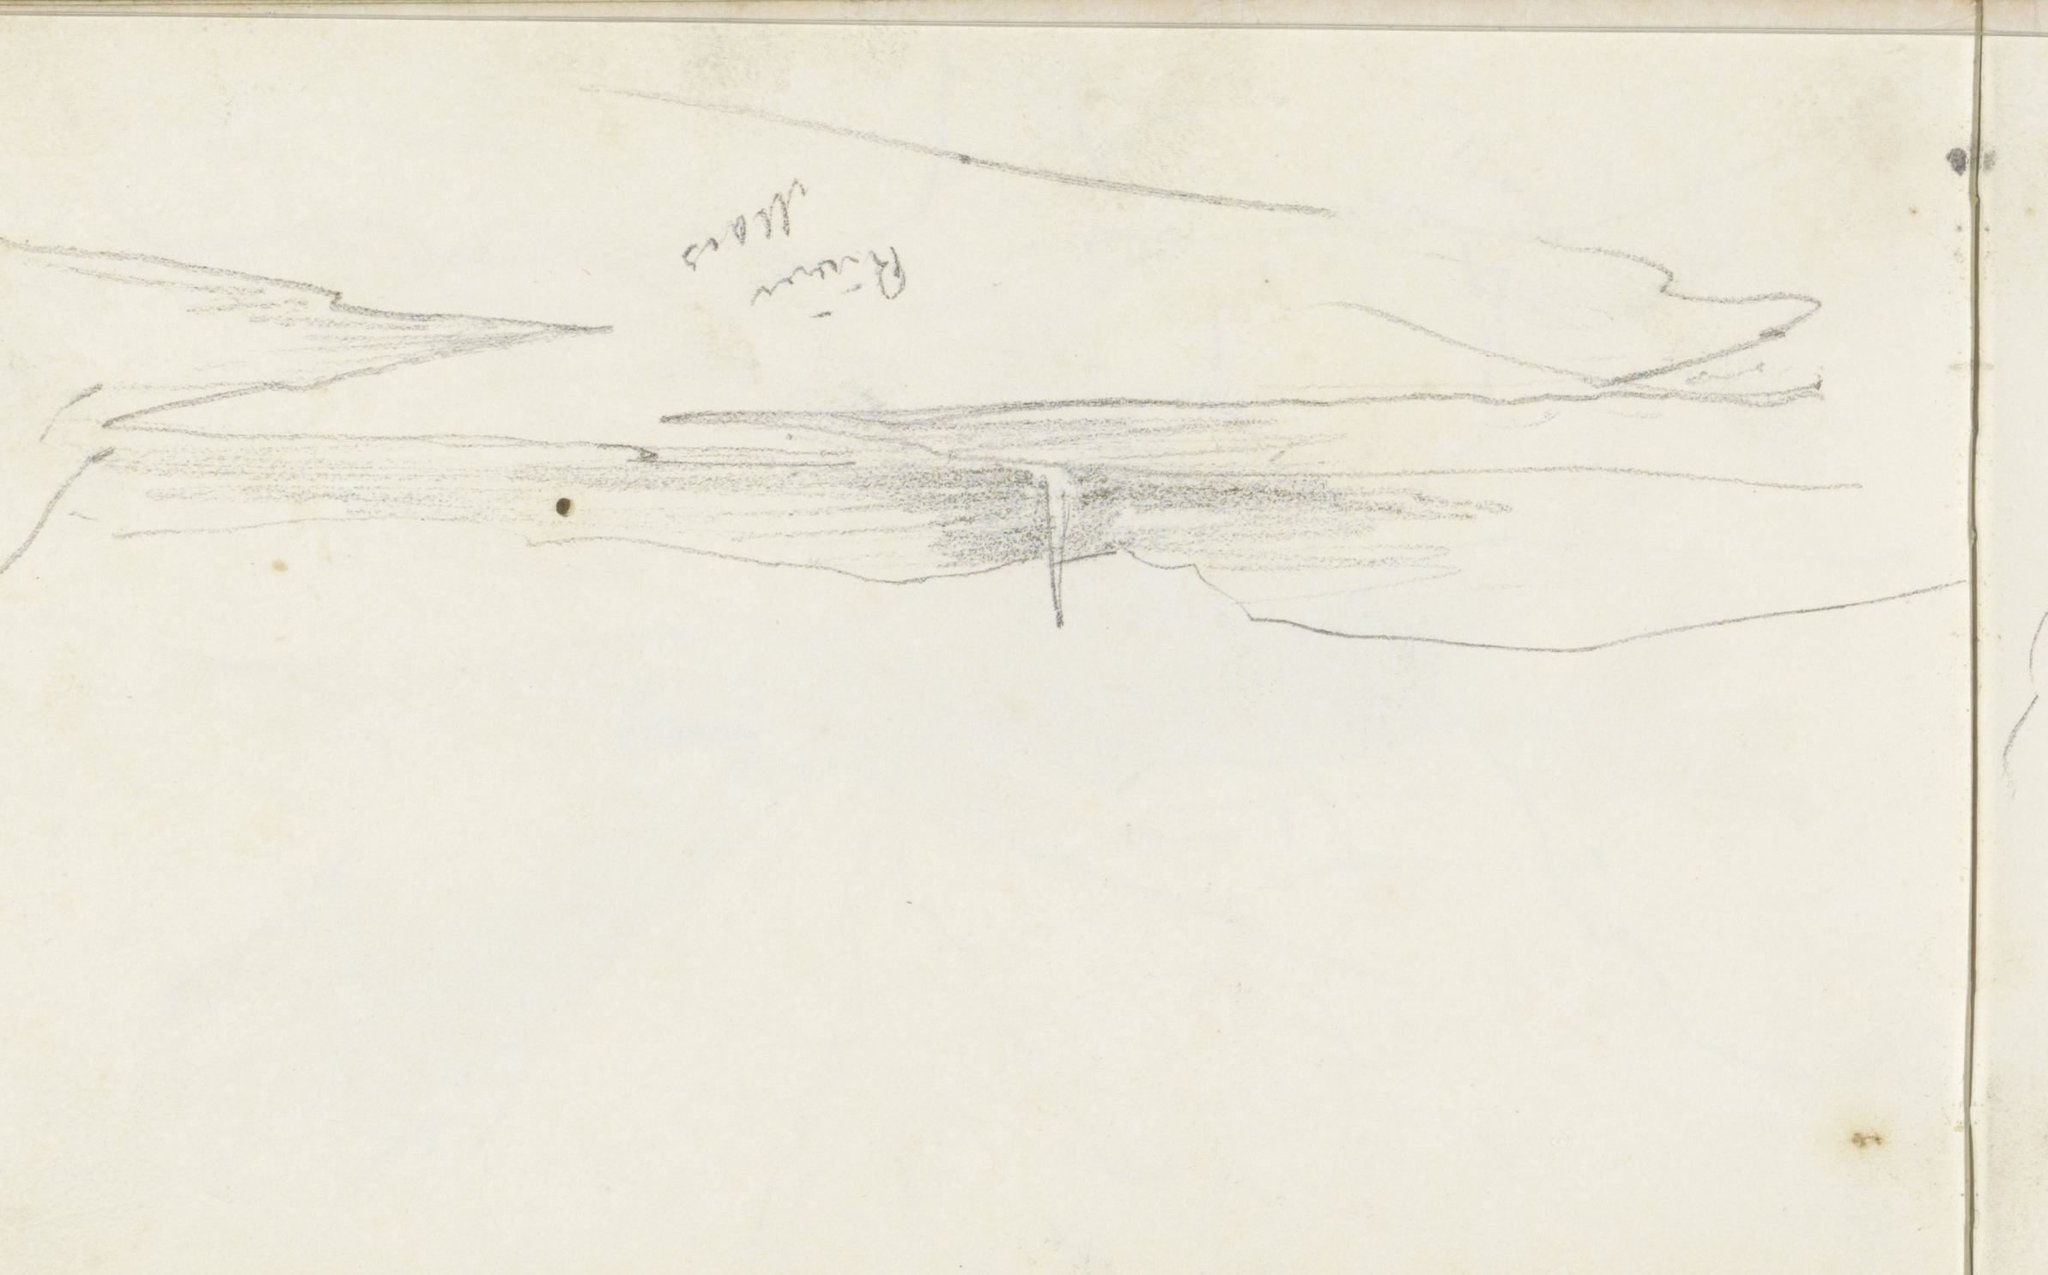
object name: sketchbook leaf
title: Heuvellandschap aan de Maas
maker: johannes tavenraat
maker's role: draughtsman, painter, print maker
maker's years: 1809-1881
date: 1840-1841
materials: paper, pencil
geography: meuse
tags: low hill country, landscapes with waters, waterscapes, seascapes (in the temperate zone)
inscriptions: annotation: ‘Rivier/ Maas’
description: Blad 26 verso uit een schetsboek met 41 bladen.